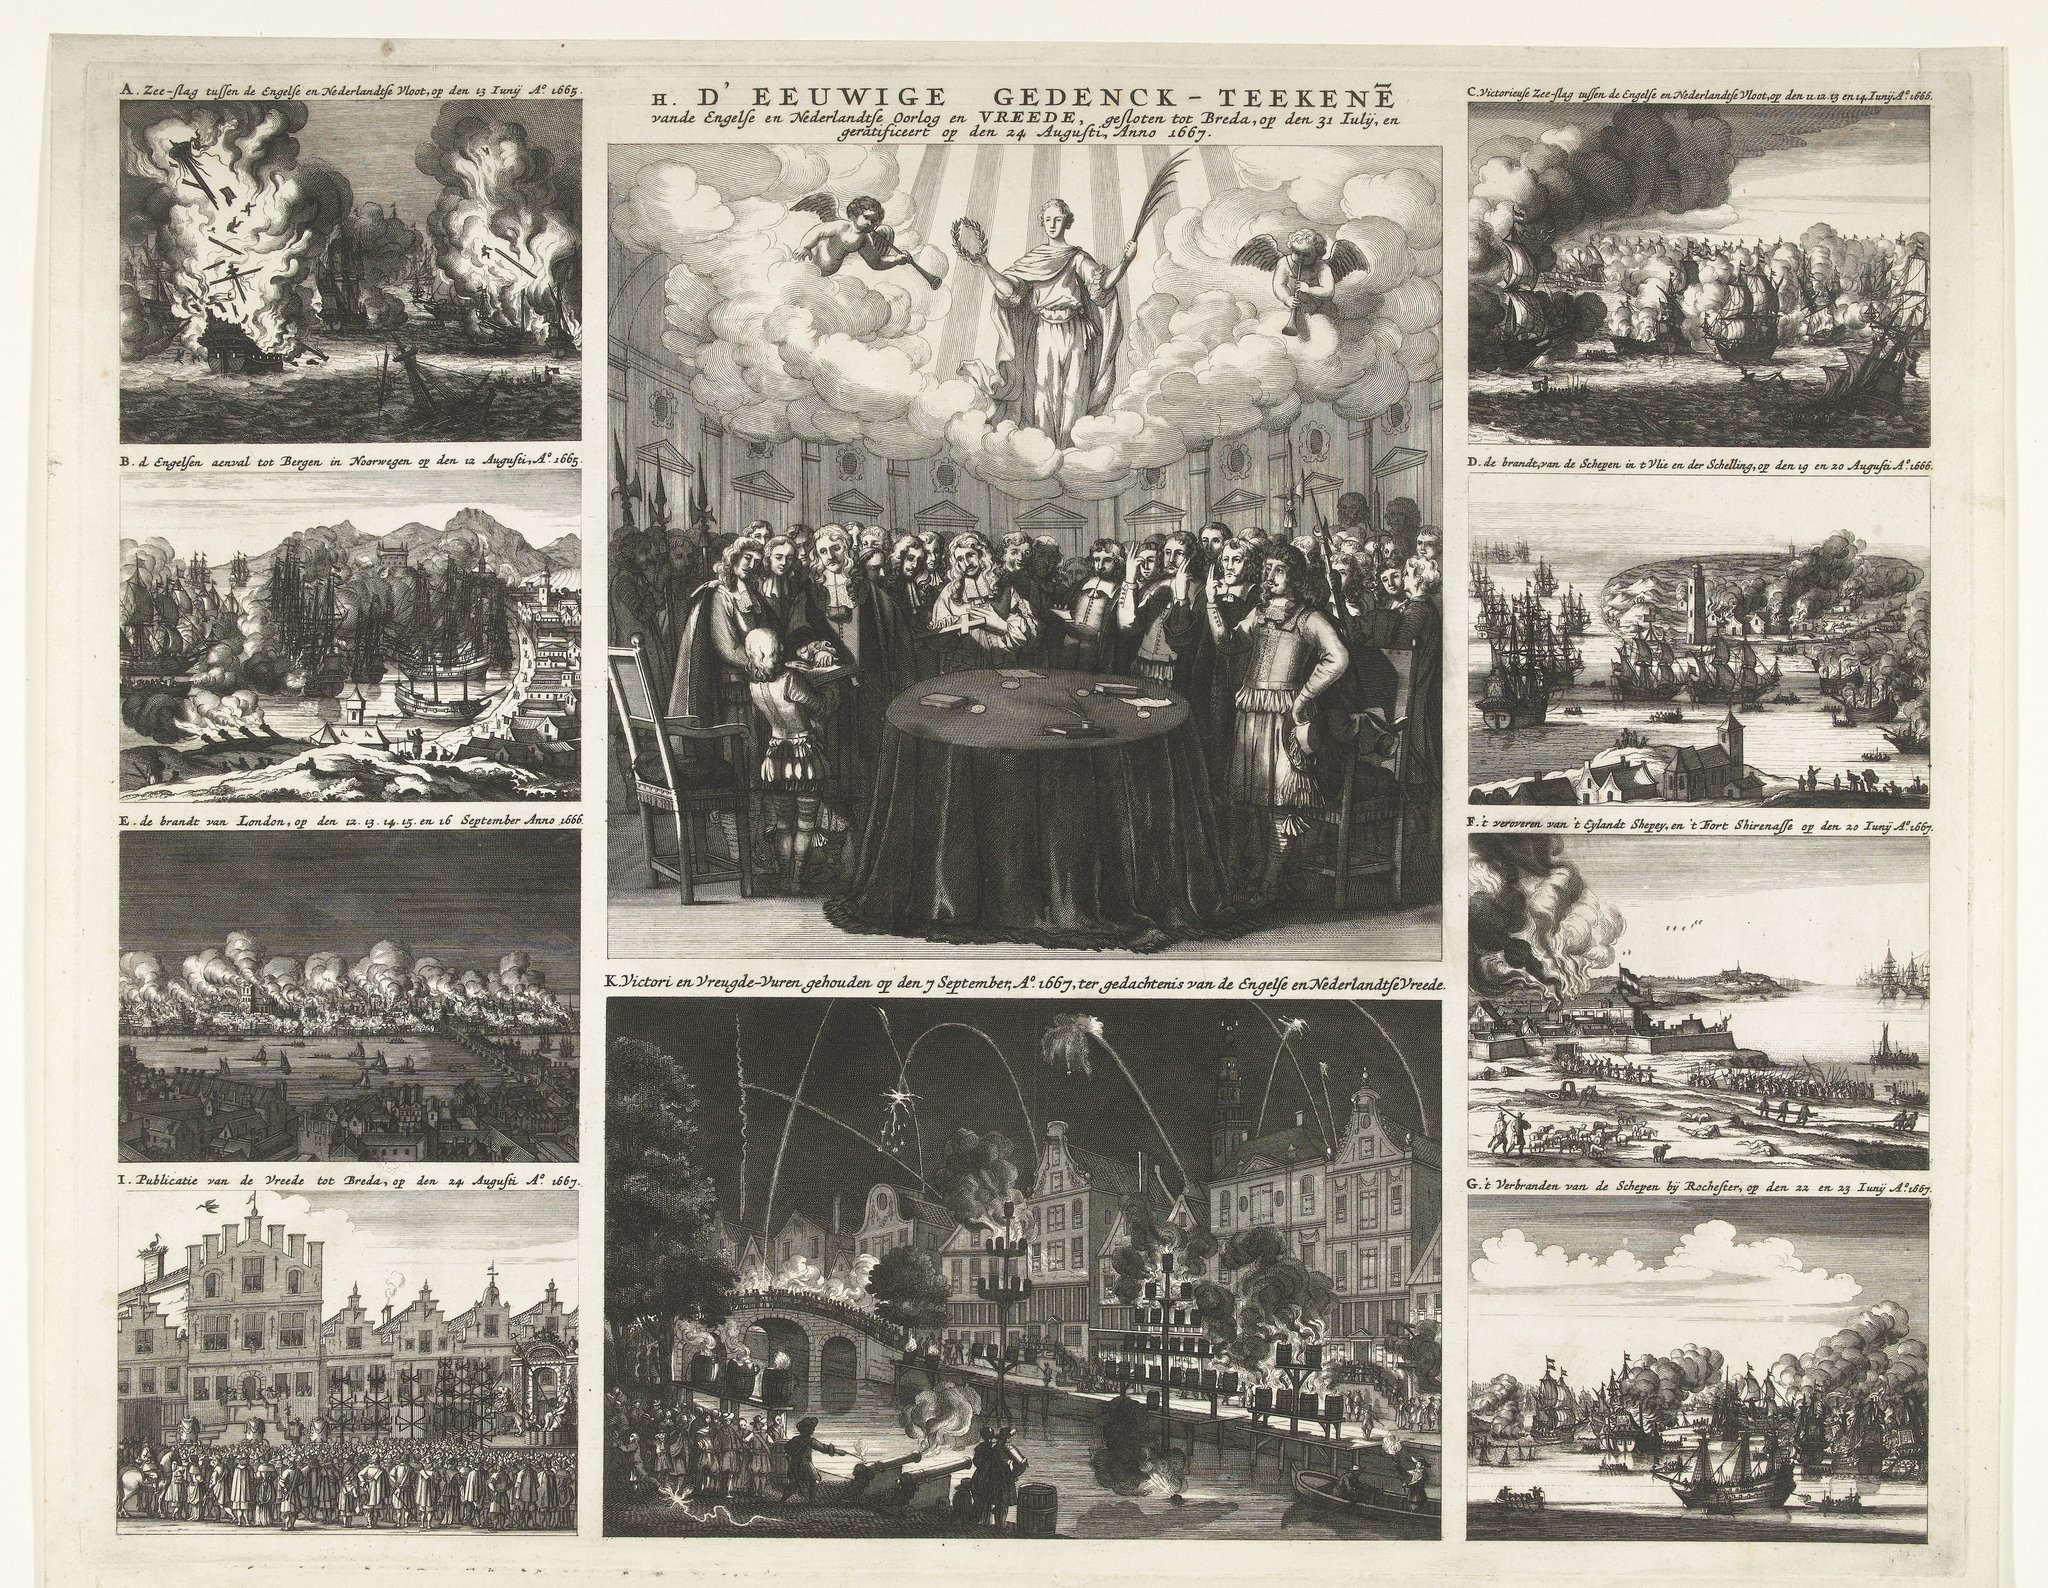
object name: print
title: Vrede van Breda, 1667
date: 1667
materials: paper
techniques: etching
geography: amsterdam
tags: battle (+ naval force), proclamation of peace, bonfire, fire-works, signing of peace treaty, concluding the peace, swearing an oath (with two fingers raised), amsterdam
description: De beëdiging van de Vrede van Breda door de Engelse en de Nederlandse gedelegeerden op 31 juli 1667 waarmee een eind kwam aan de Tweede Engelse Oorlog. Centrale voorstelling met het beëdigen van het vredesverdrag, boven de aanwezigen de personificatie van de Vrede in een wolk met twee engeltjes met bazuinen. Hieromheen negen kleine voorstellingen van de zeeslagen uitgevochten tijdens deze oorlog, de bekendmaking van de vrede te Breda op 24 augustus en de vreugdevuren te Amsterdam op 7 september 1667. Alle scènes aangeduid met de letters A-K en voorzien van een onderschrift. Bij de prent behoort een tekstblad.